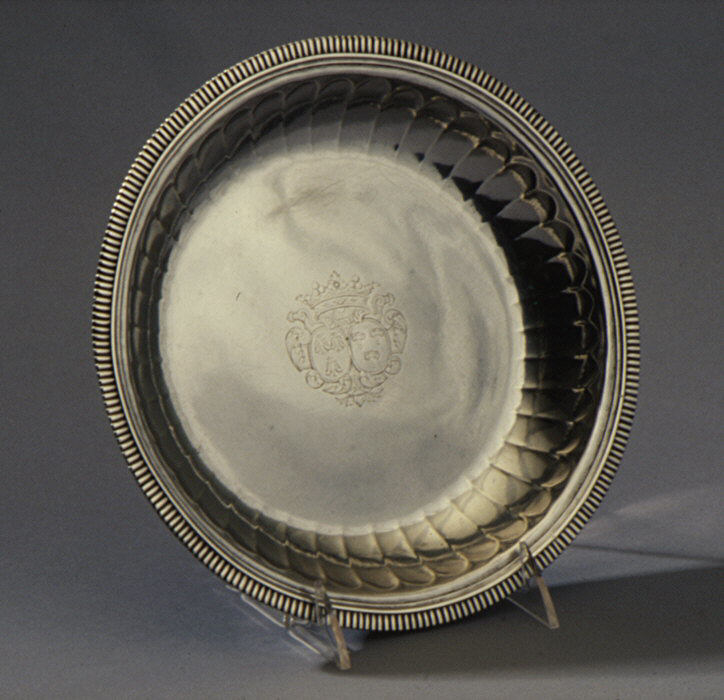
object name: dish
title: Dish (one of a pair)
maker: jérôme rebillé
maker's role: maker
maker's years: 1685-1740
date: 1720-1726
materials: silver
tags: coat of arms